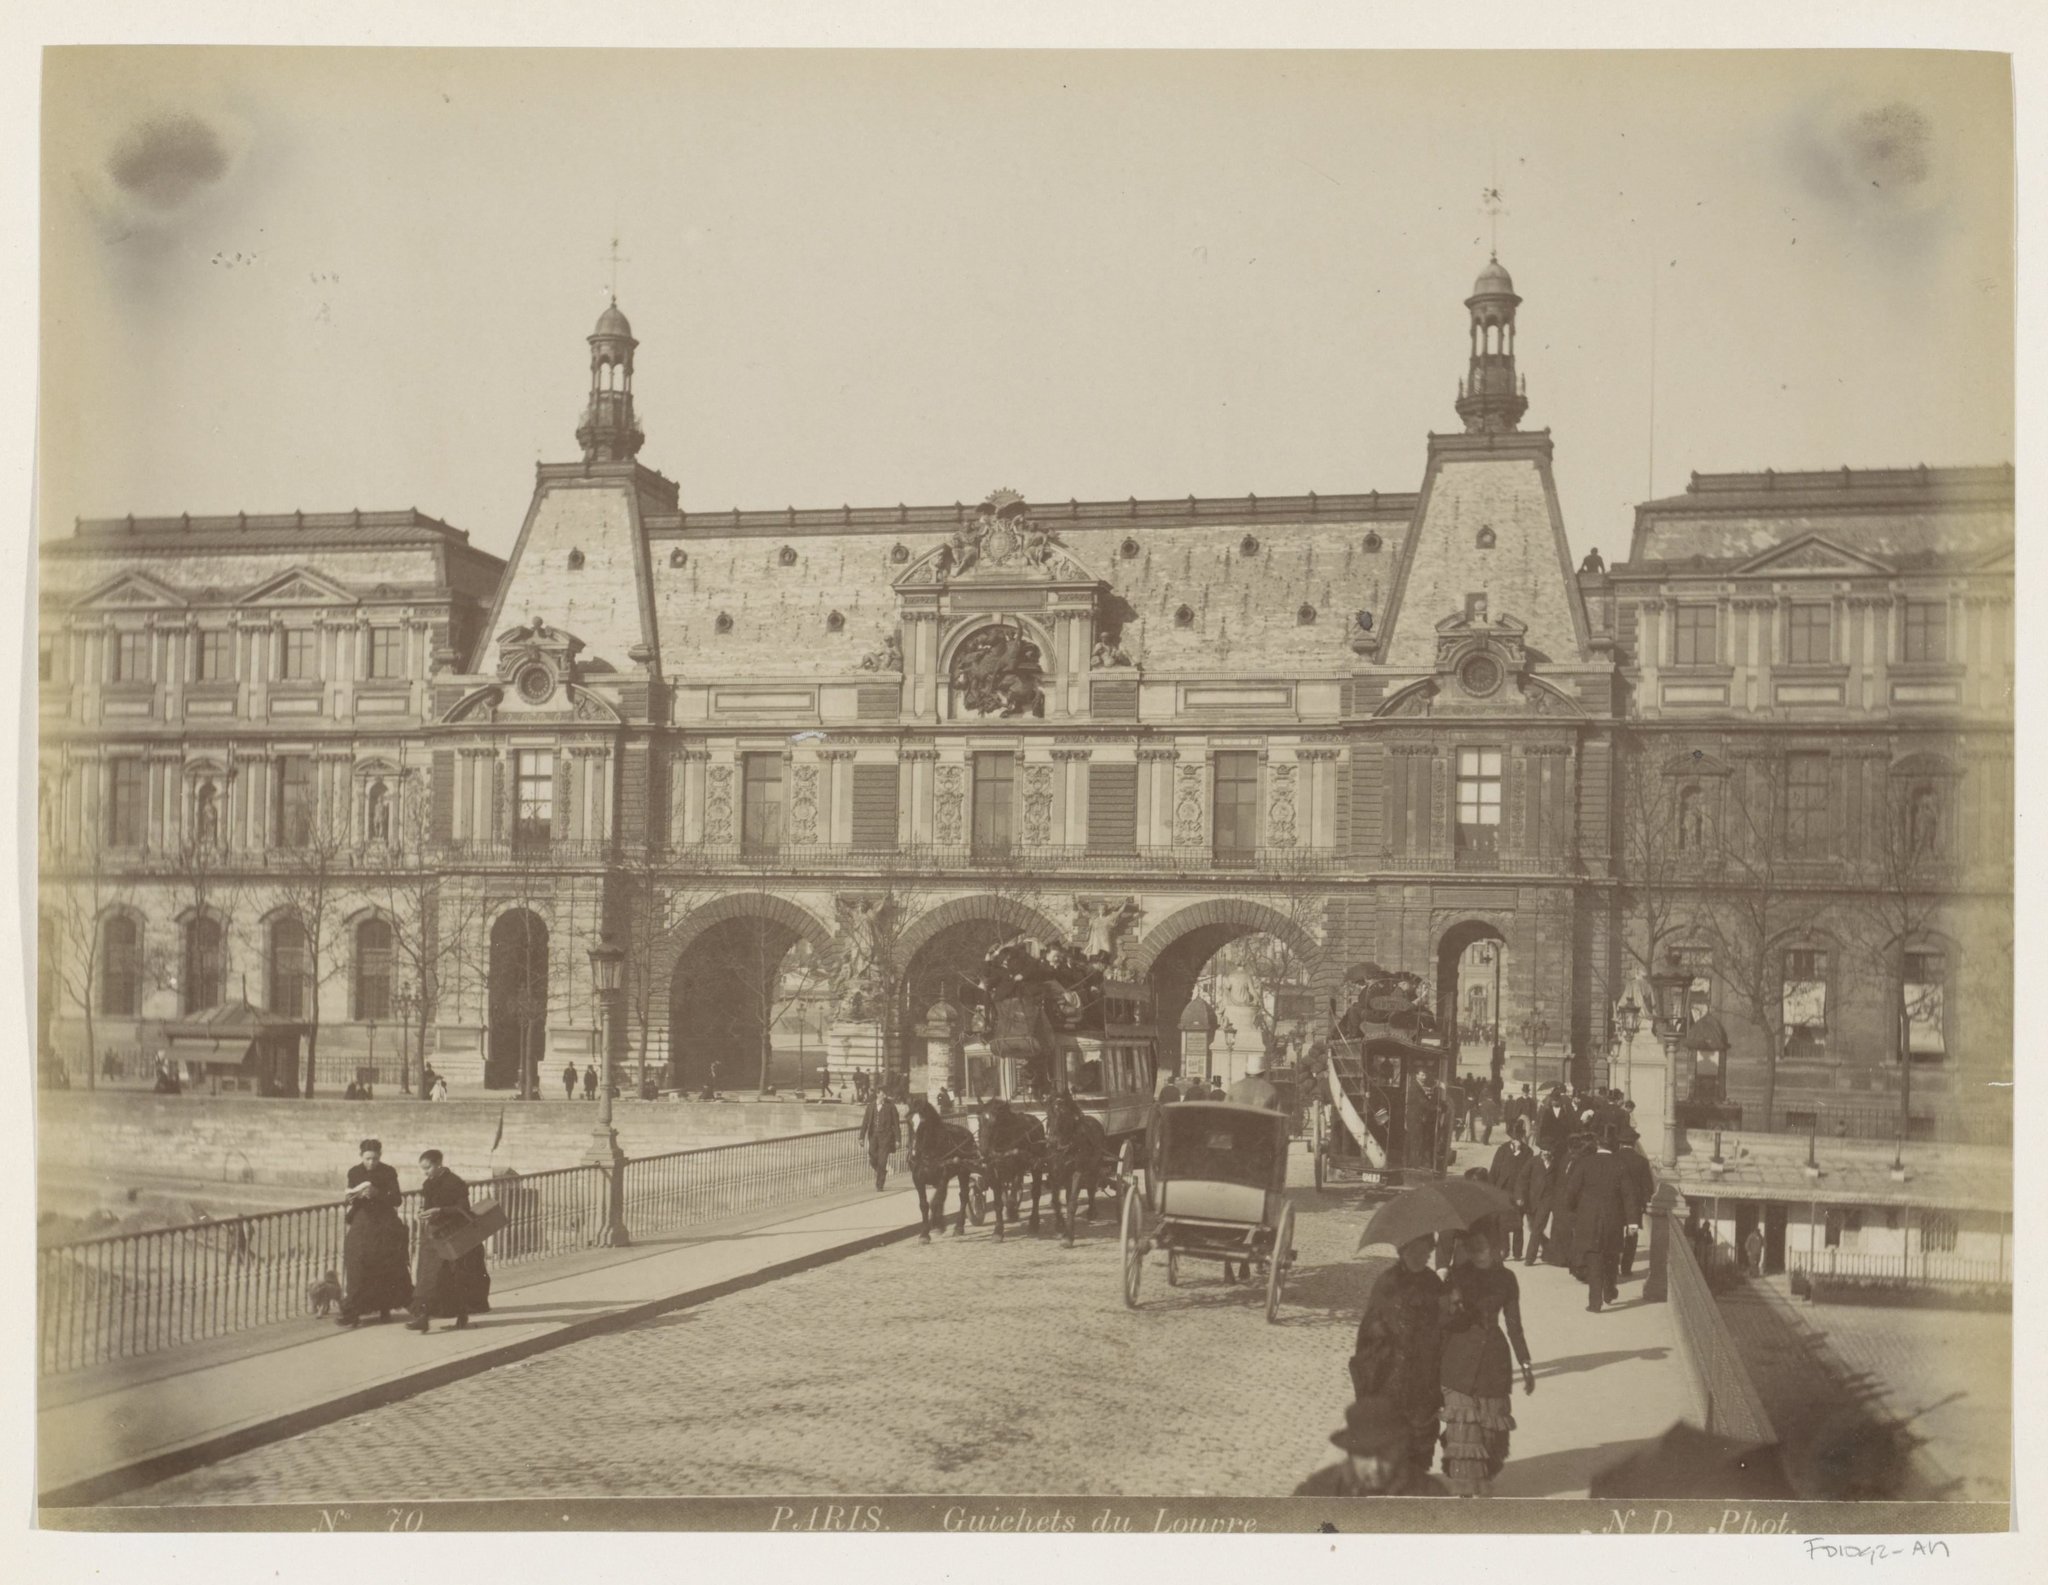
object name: photograph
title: Voorbijgangers en paardenkoetsen bij de poorten van het Louvre in Parijs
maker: étienne neurdein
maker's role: publisher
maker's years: 1832-1918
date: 1880-1900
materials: cardboard, paper, photographic support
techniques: albumen print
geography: paris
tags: four-wheeled, animal-drawn vehicle, e.g.: cab, carriage, coach, gate, entrance, permanent exhibition, museum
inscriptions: negative number: ‘70’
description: Onderdeel van Reisalbum met foto's van bezienswaardigheden in België en Frankrijk.